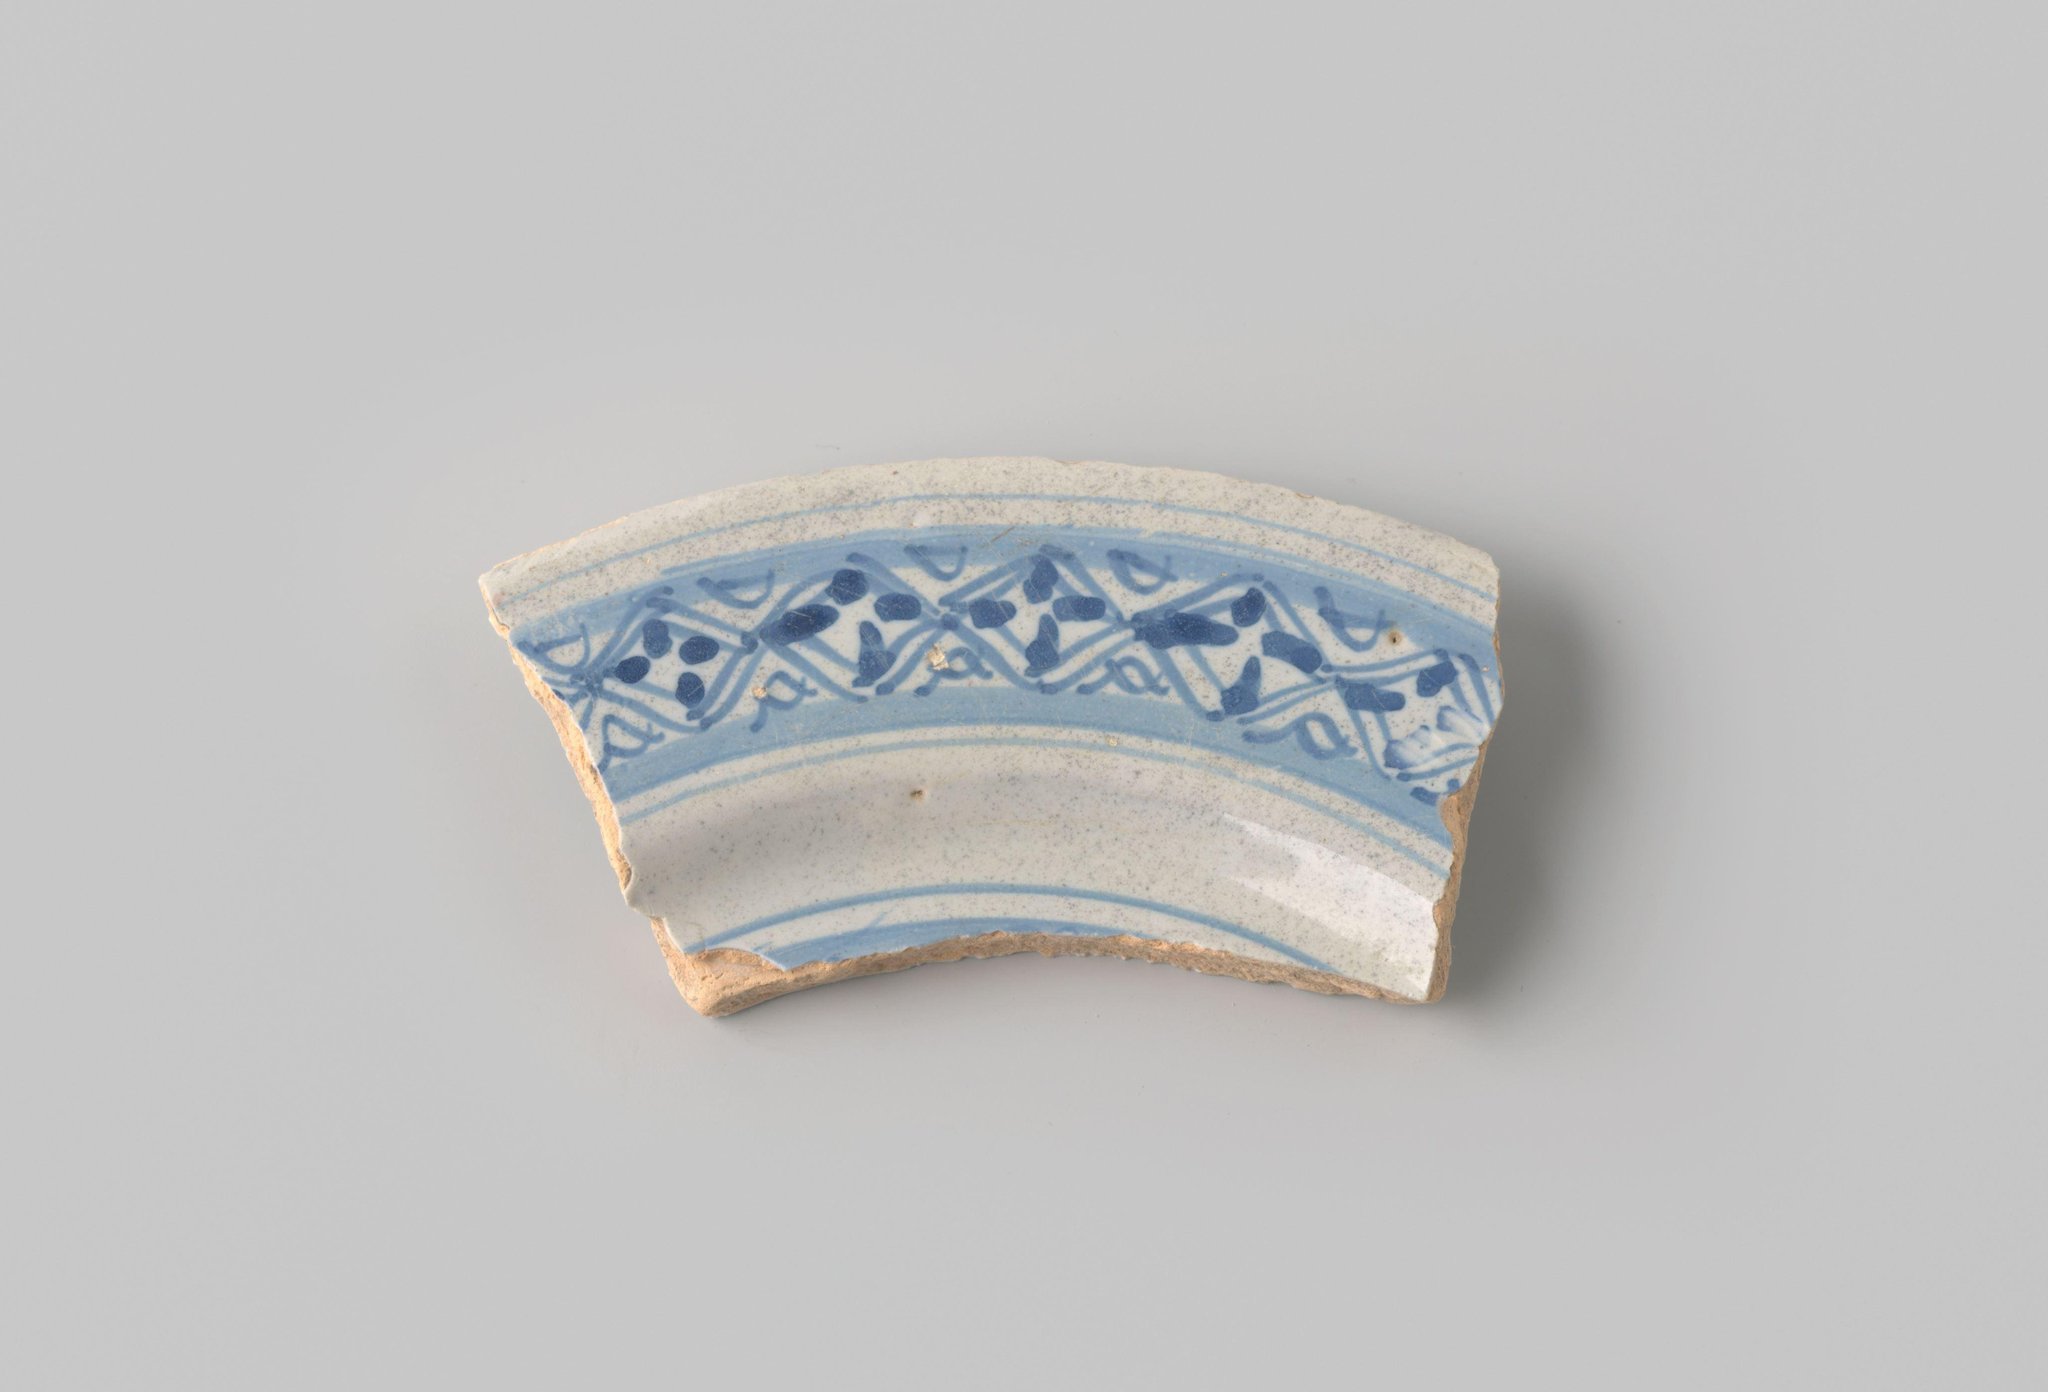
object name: fragment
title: Scherf van rossig bakkend aardewerk, voorzien van lichtgrijs glazuur, aan de voorzijde voorzien van een sierrand in blauw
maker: Anonymous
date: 1600-1650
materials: earthenware, glaze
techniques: maiolica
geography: northern netherlands